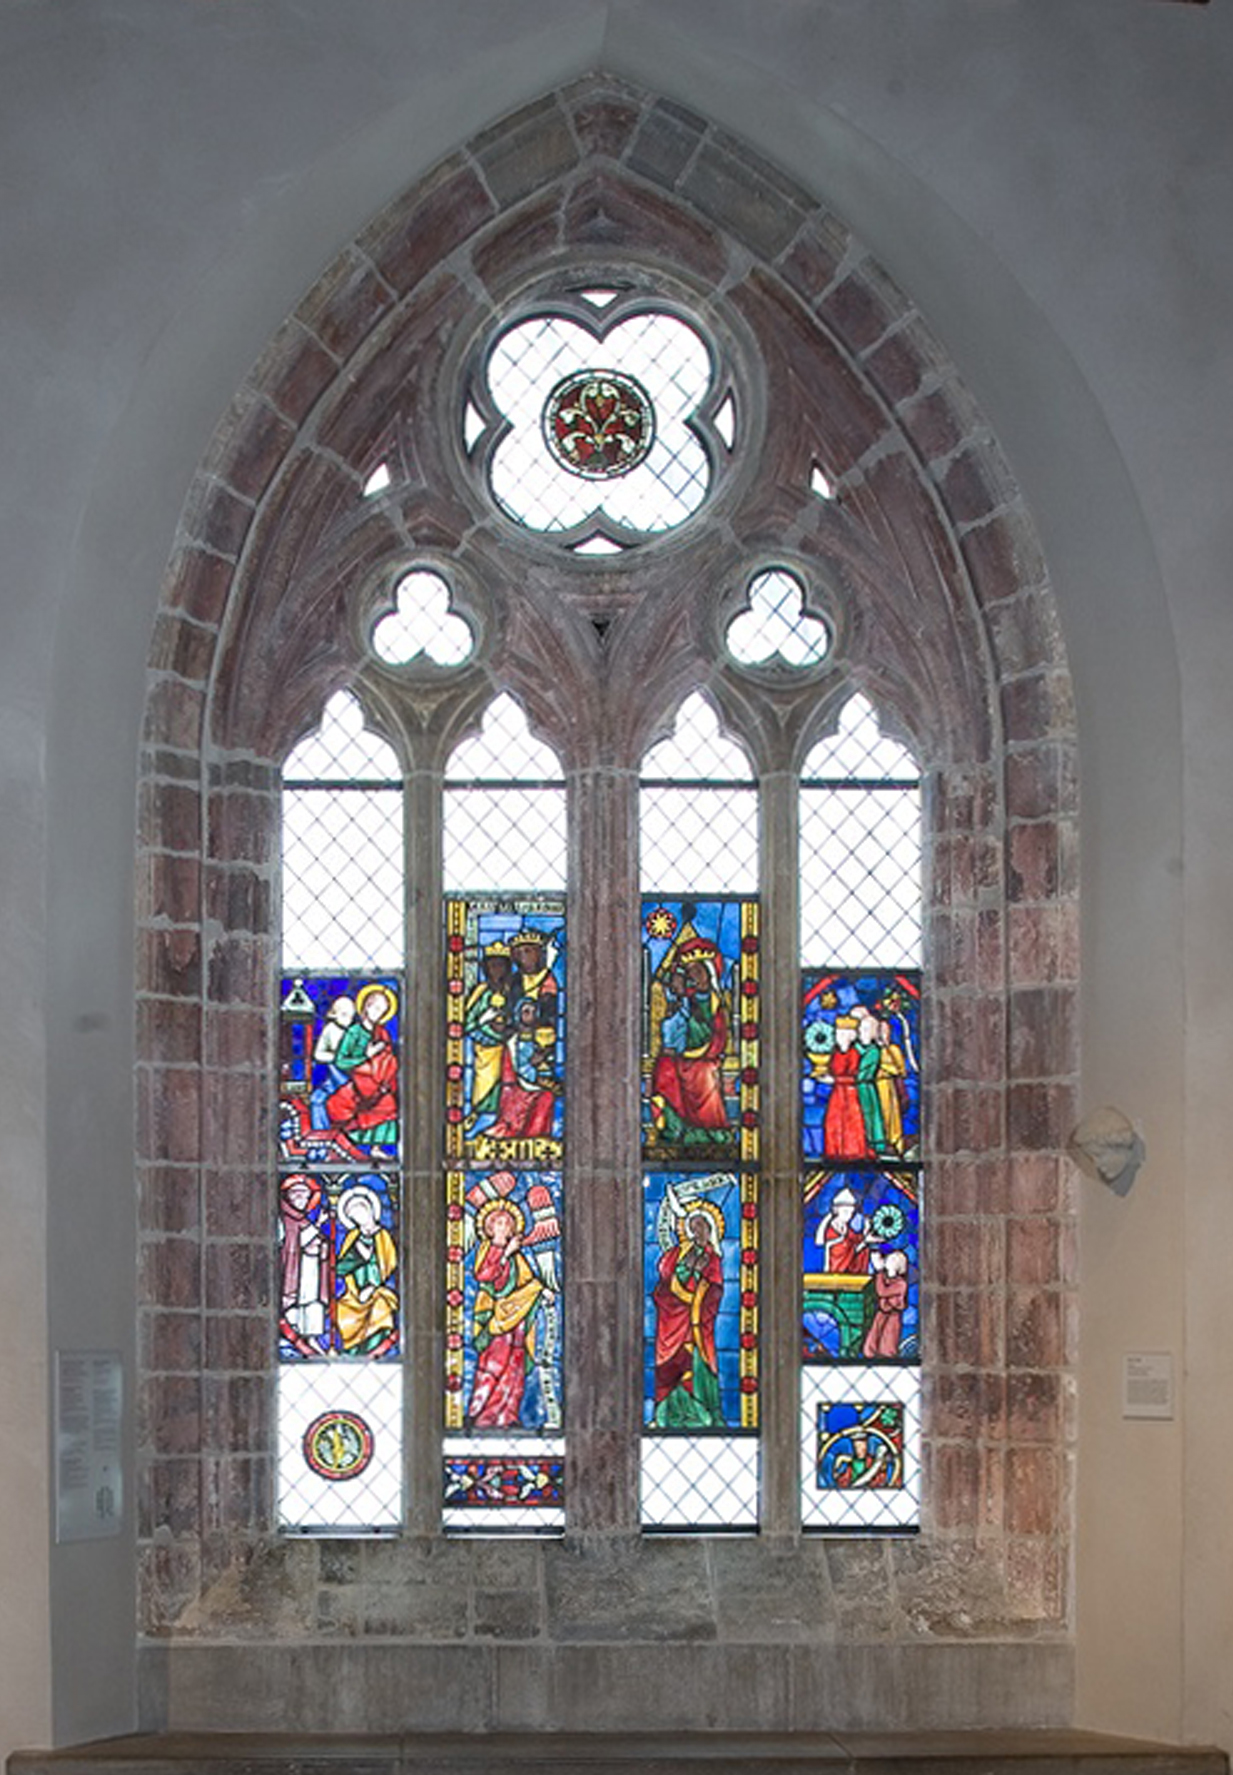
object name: window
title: Lancet Window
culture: french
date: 1250-1300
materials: limestone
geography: france